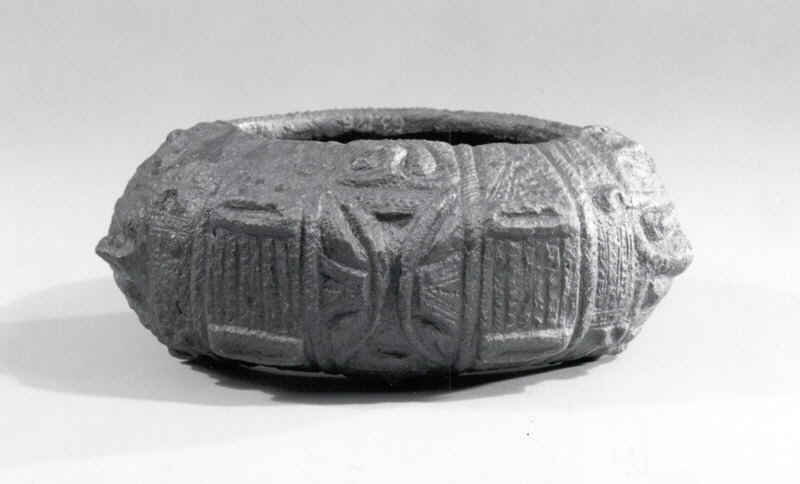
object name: bracelet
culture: iranian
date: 800-601 BCE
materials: bronze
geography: iran, probably from luristan